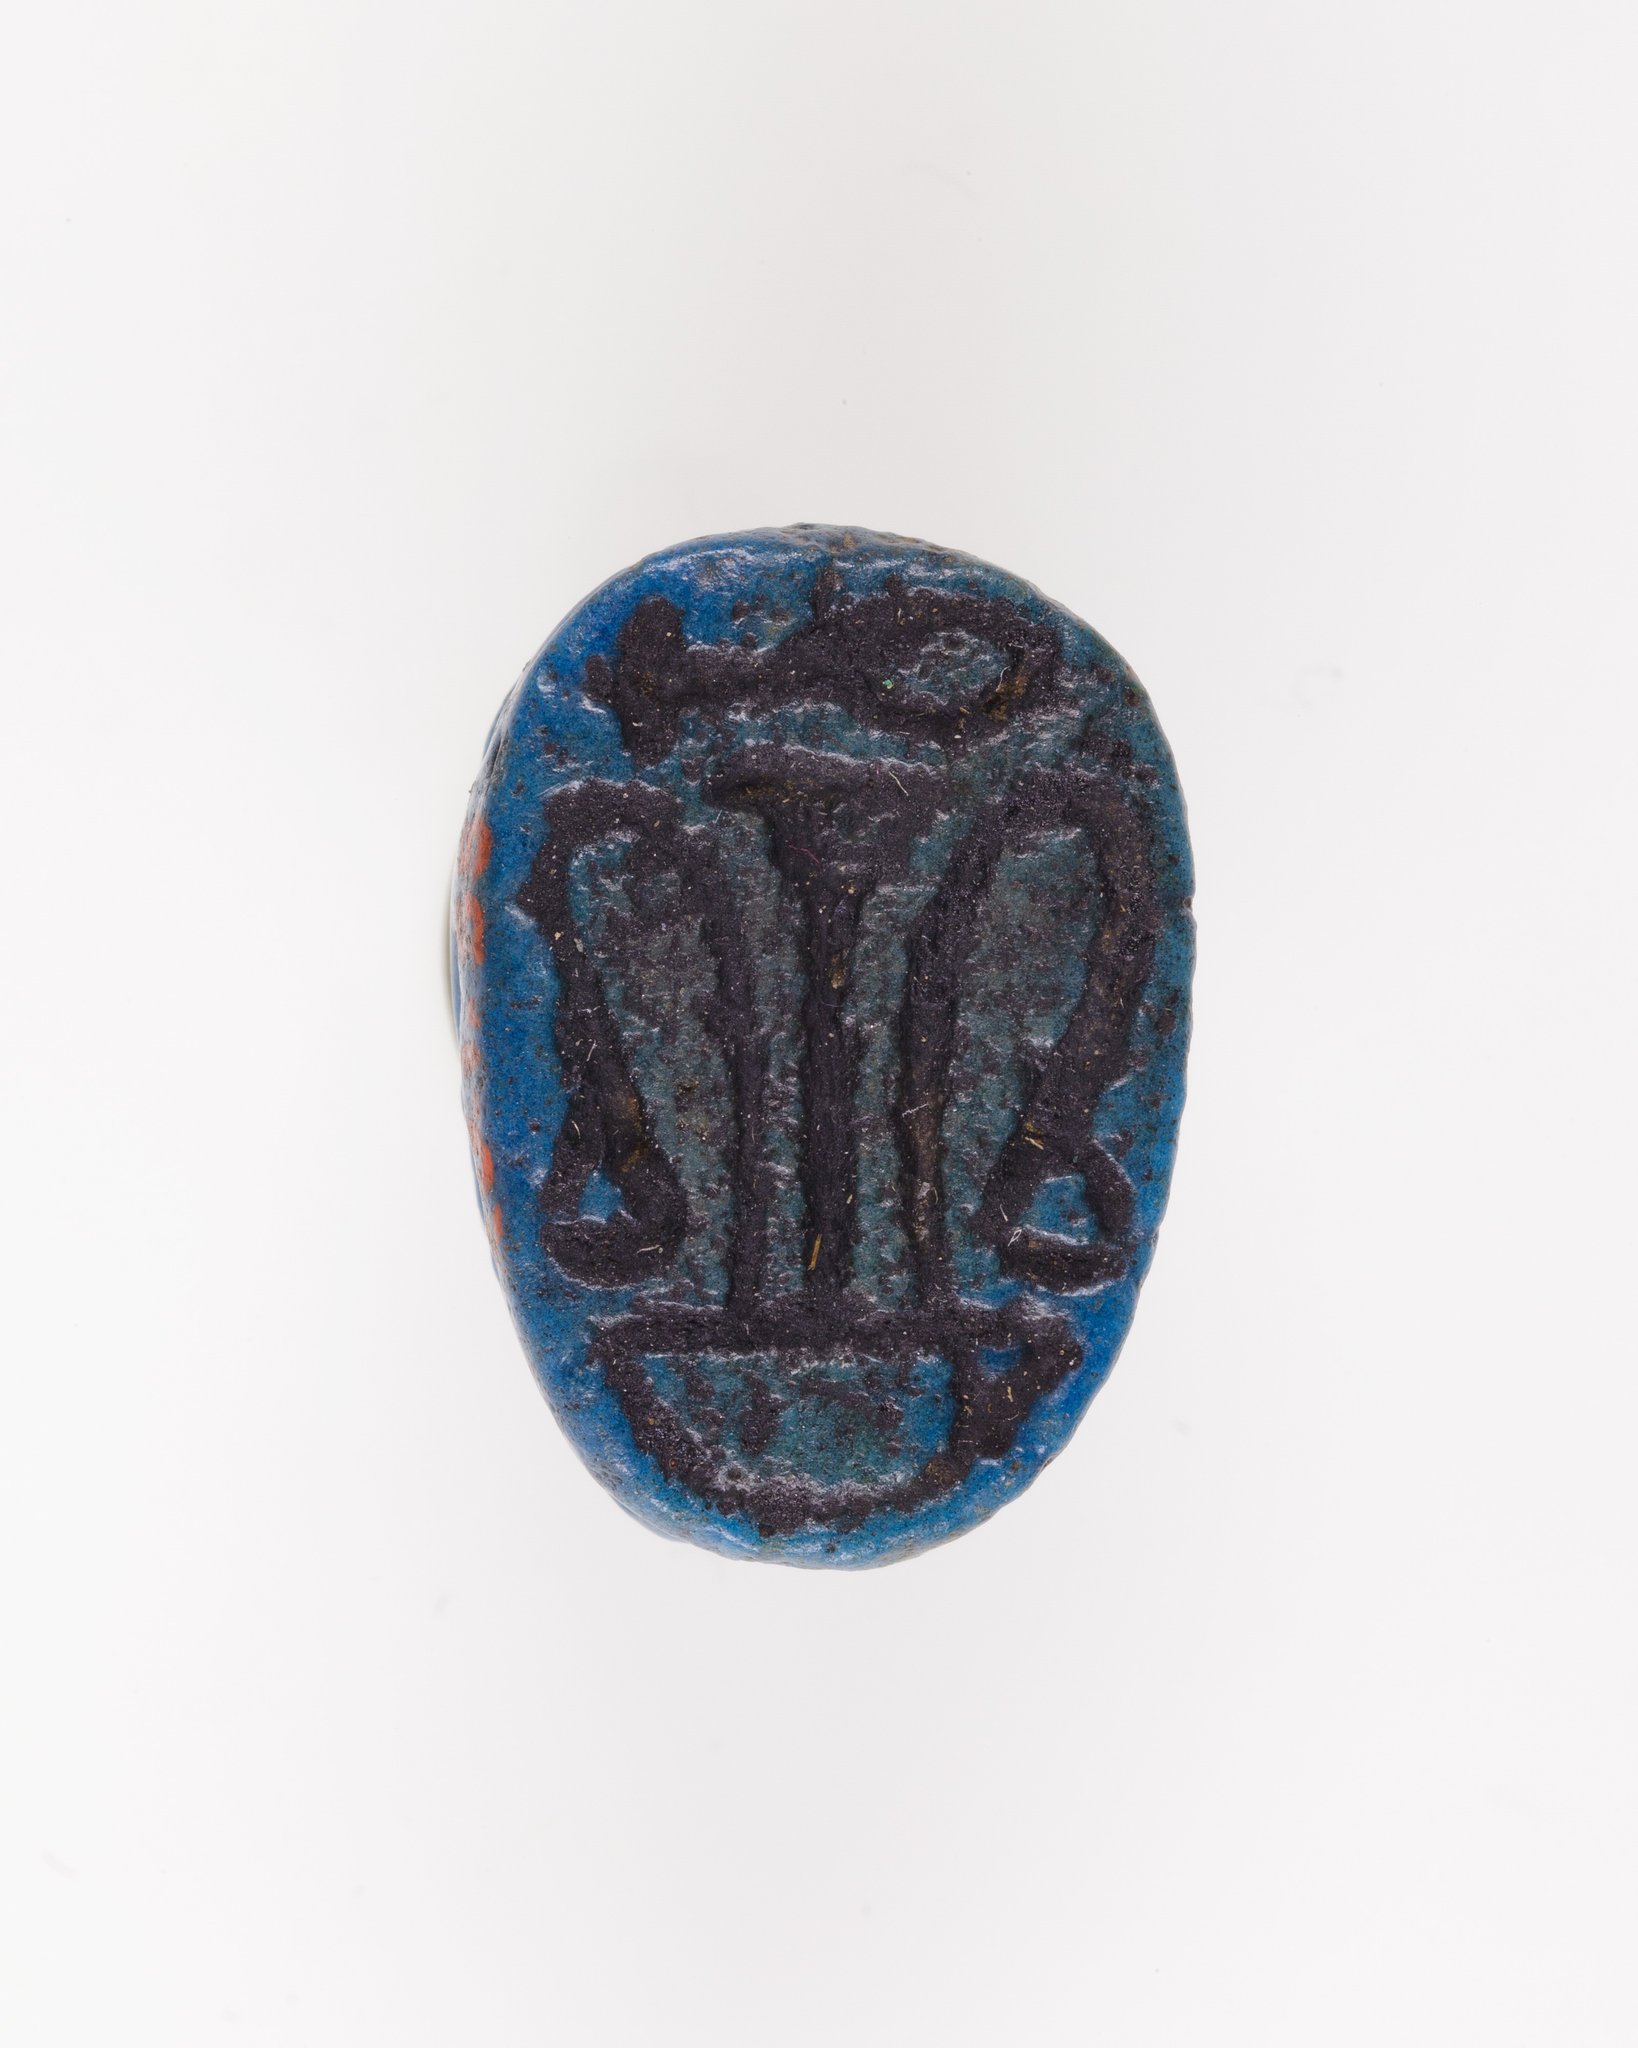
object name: scarab, papyrus, sa hieroglyph, nb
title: Scarab Incised with Hieroglyph and Papyrus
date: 1580-1550 BCE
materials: faience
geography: egypt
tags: hieroglyphs,scarabs